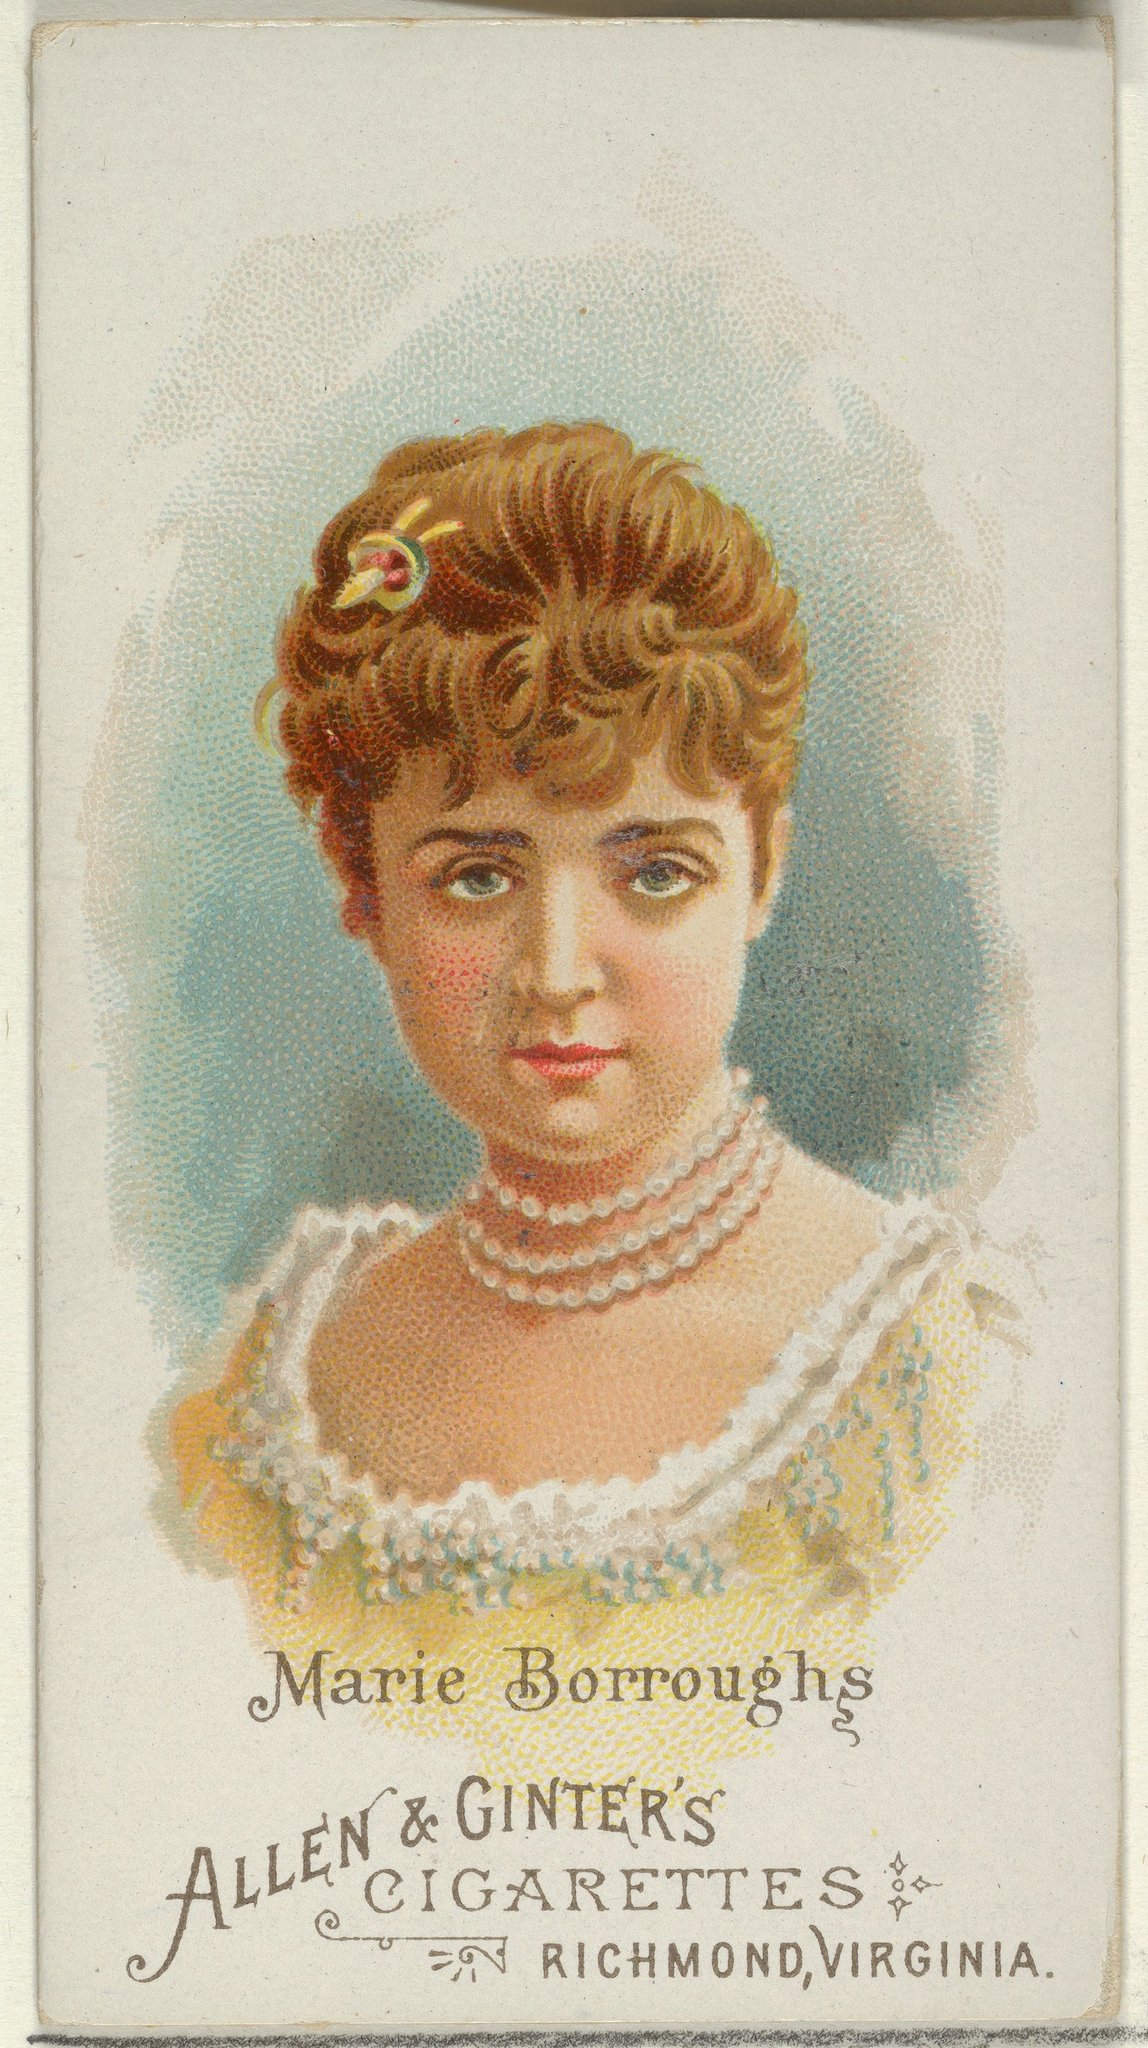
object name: print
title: Marie Borroughs, from World's Beauties, Series 1 (N26) for Allen & Ginter Cigarettes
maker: allen & ginter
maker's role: publisher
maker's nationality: american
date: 1888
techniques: color lithograph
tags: women